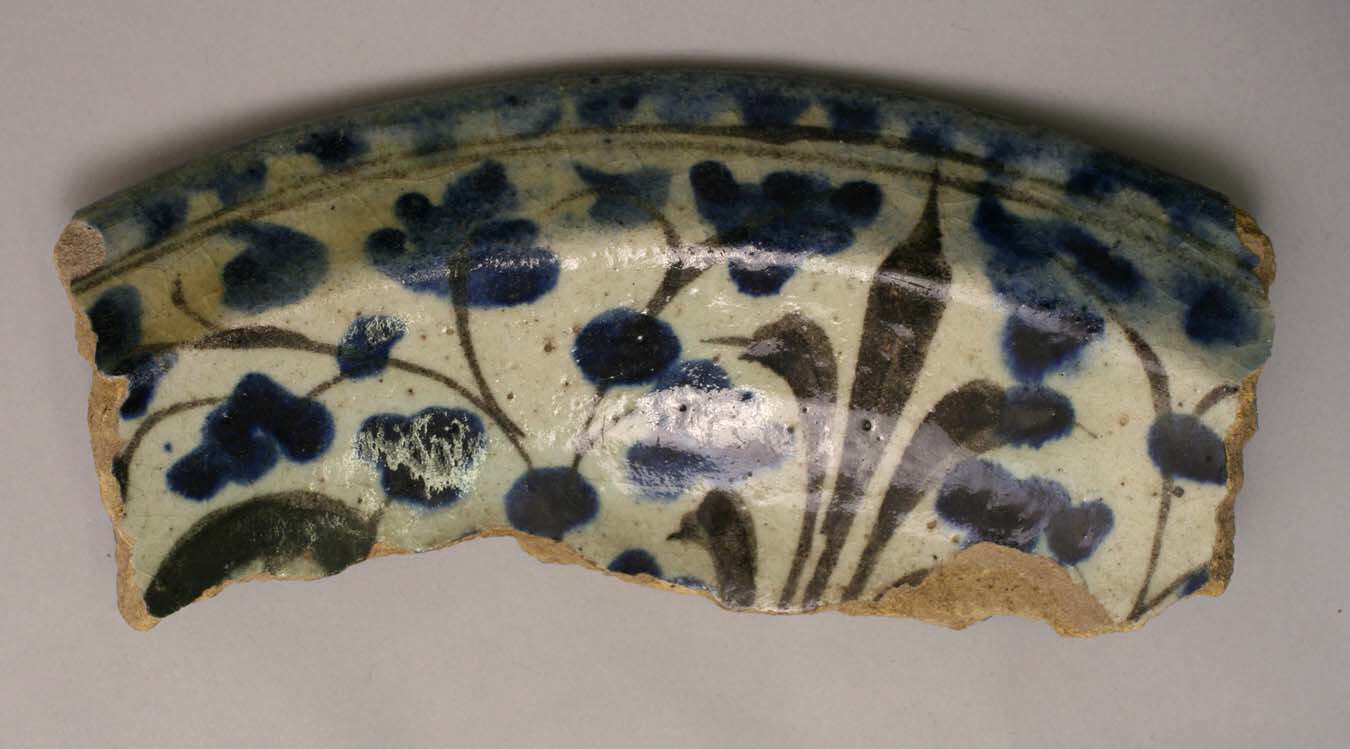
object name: fragment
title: Ceramic Fragment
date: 1301-1500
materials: glaze, stonepaste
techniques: painting, polychrome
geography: syria